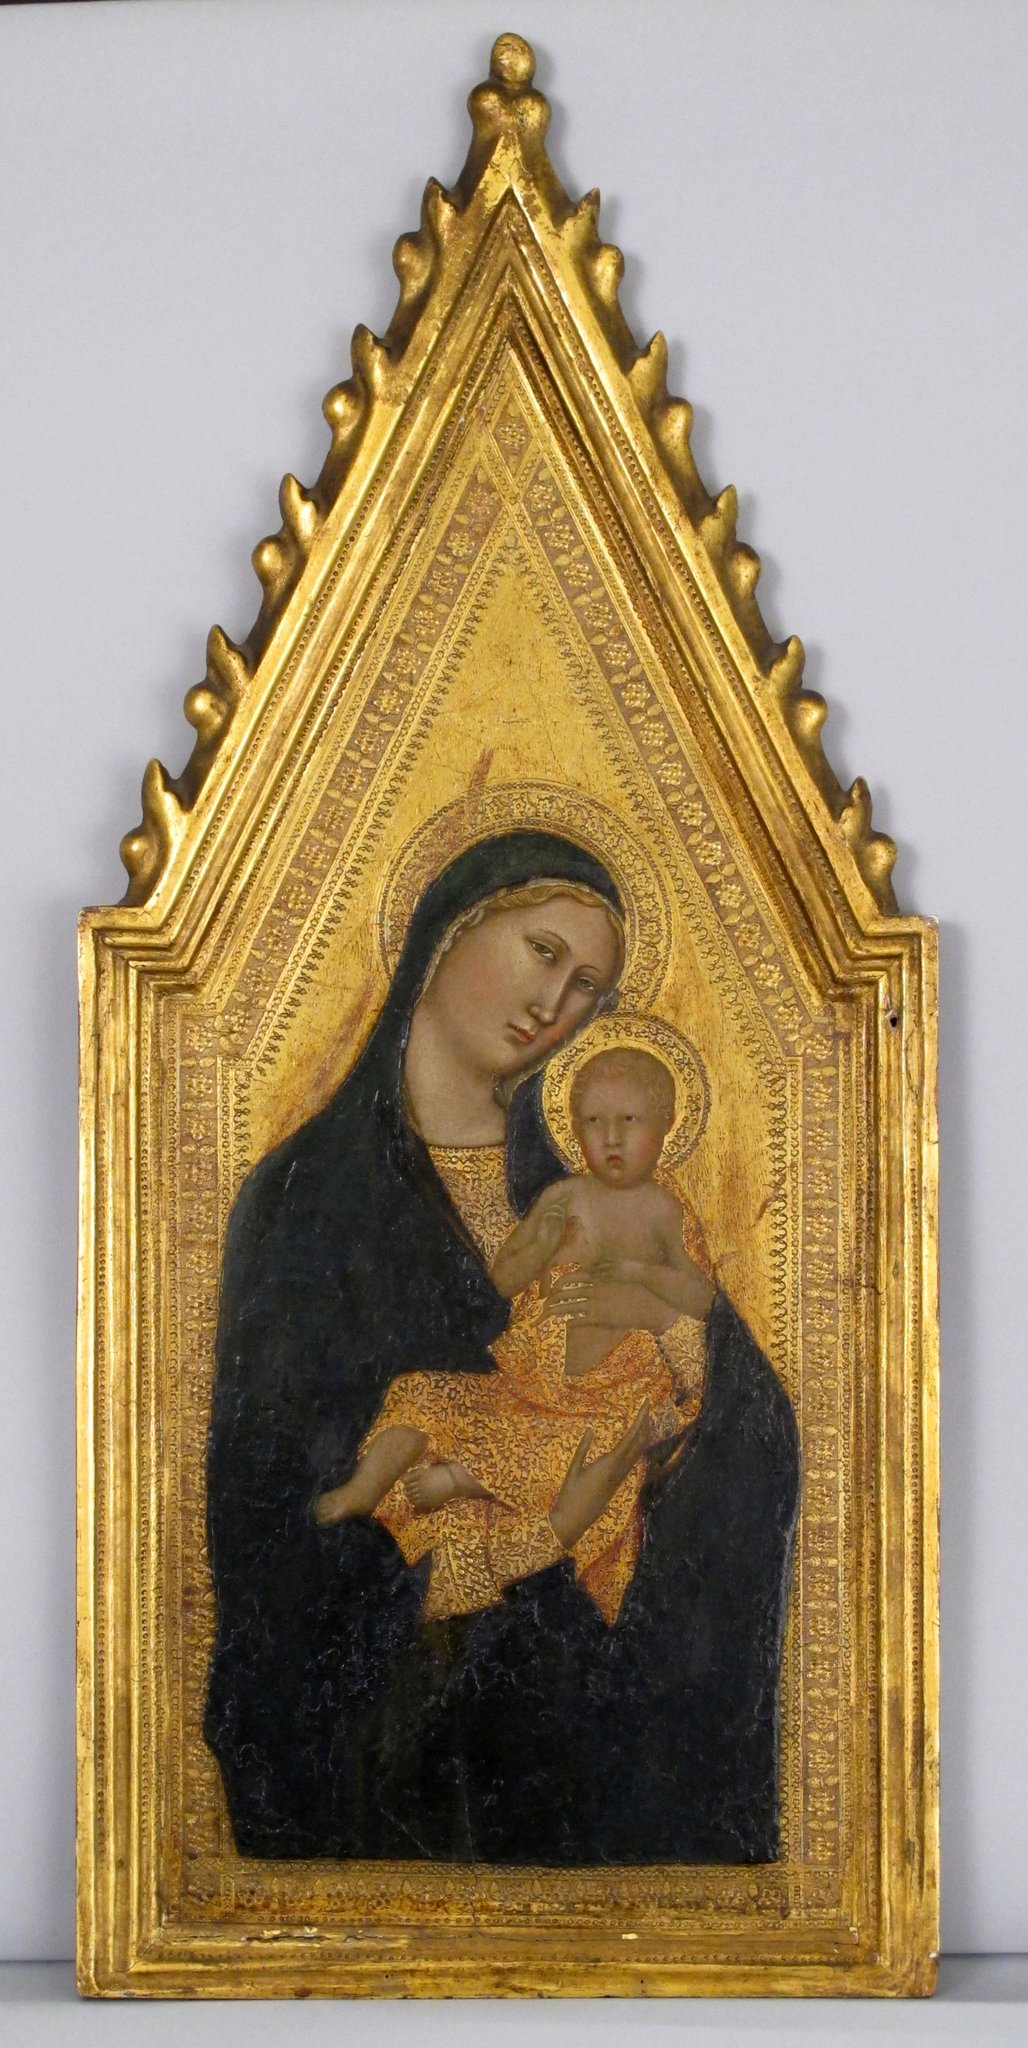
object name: frame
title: Tabernacle frame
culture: italian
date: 1326-1350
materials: gold, wood